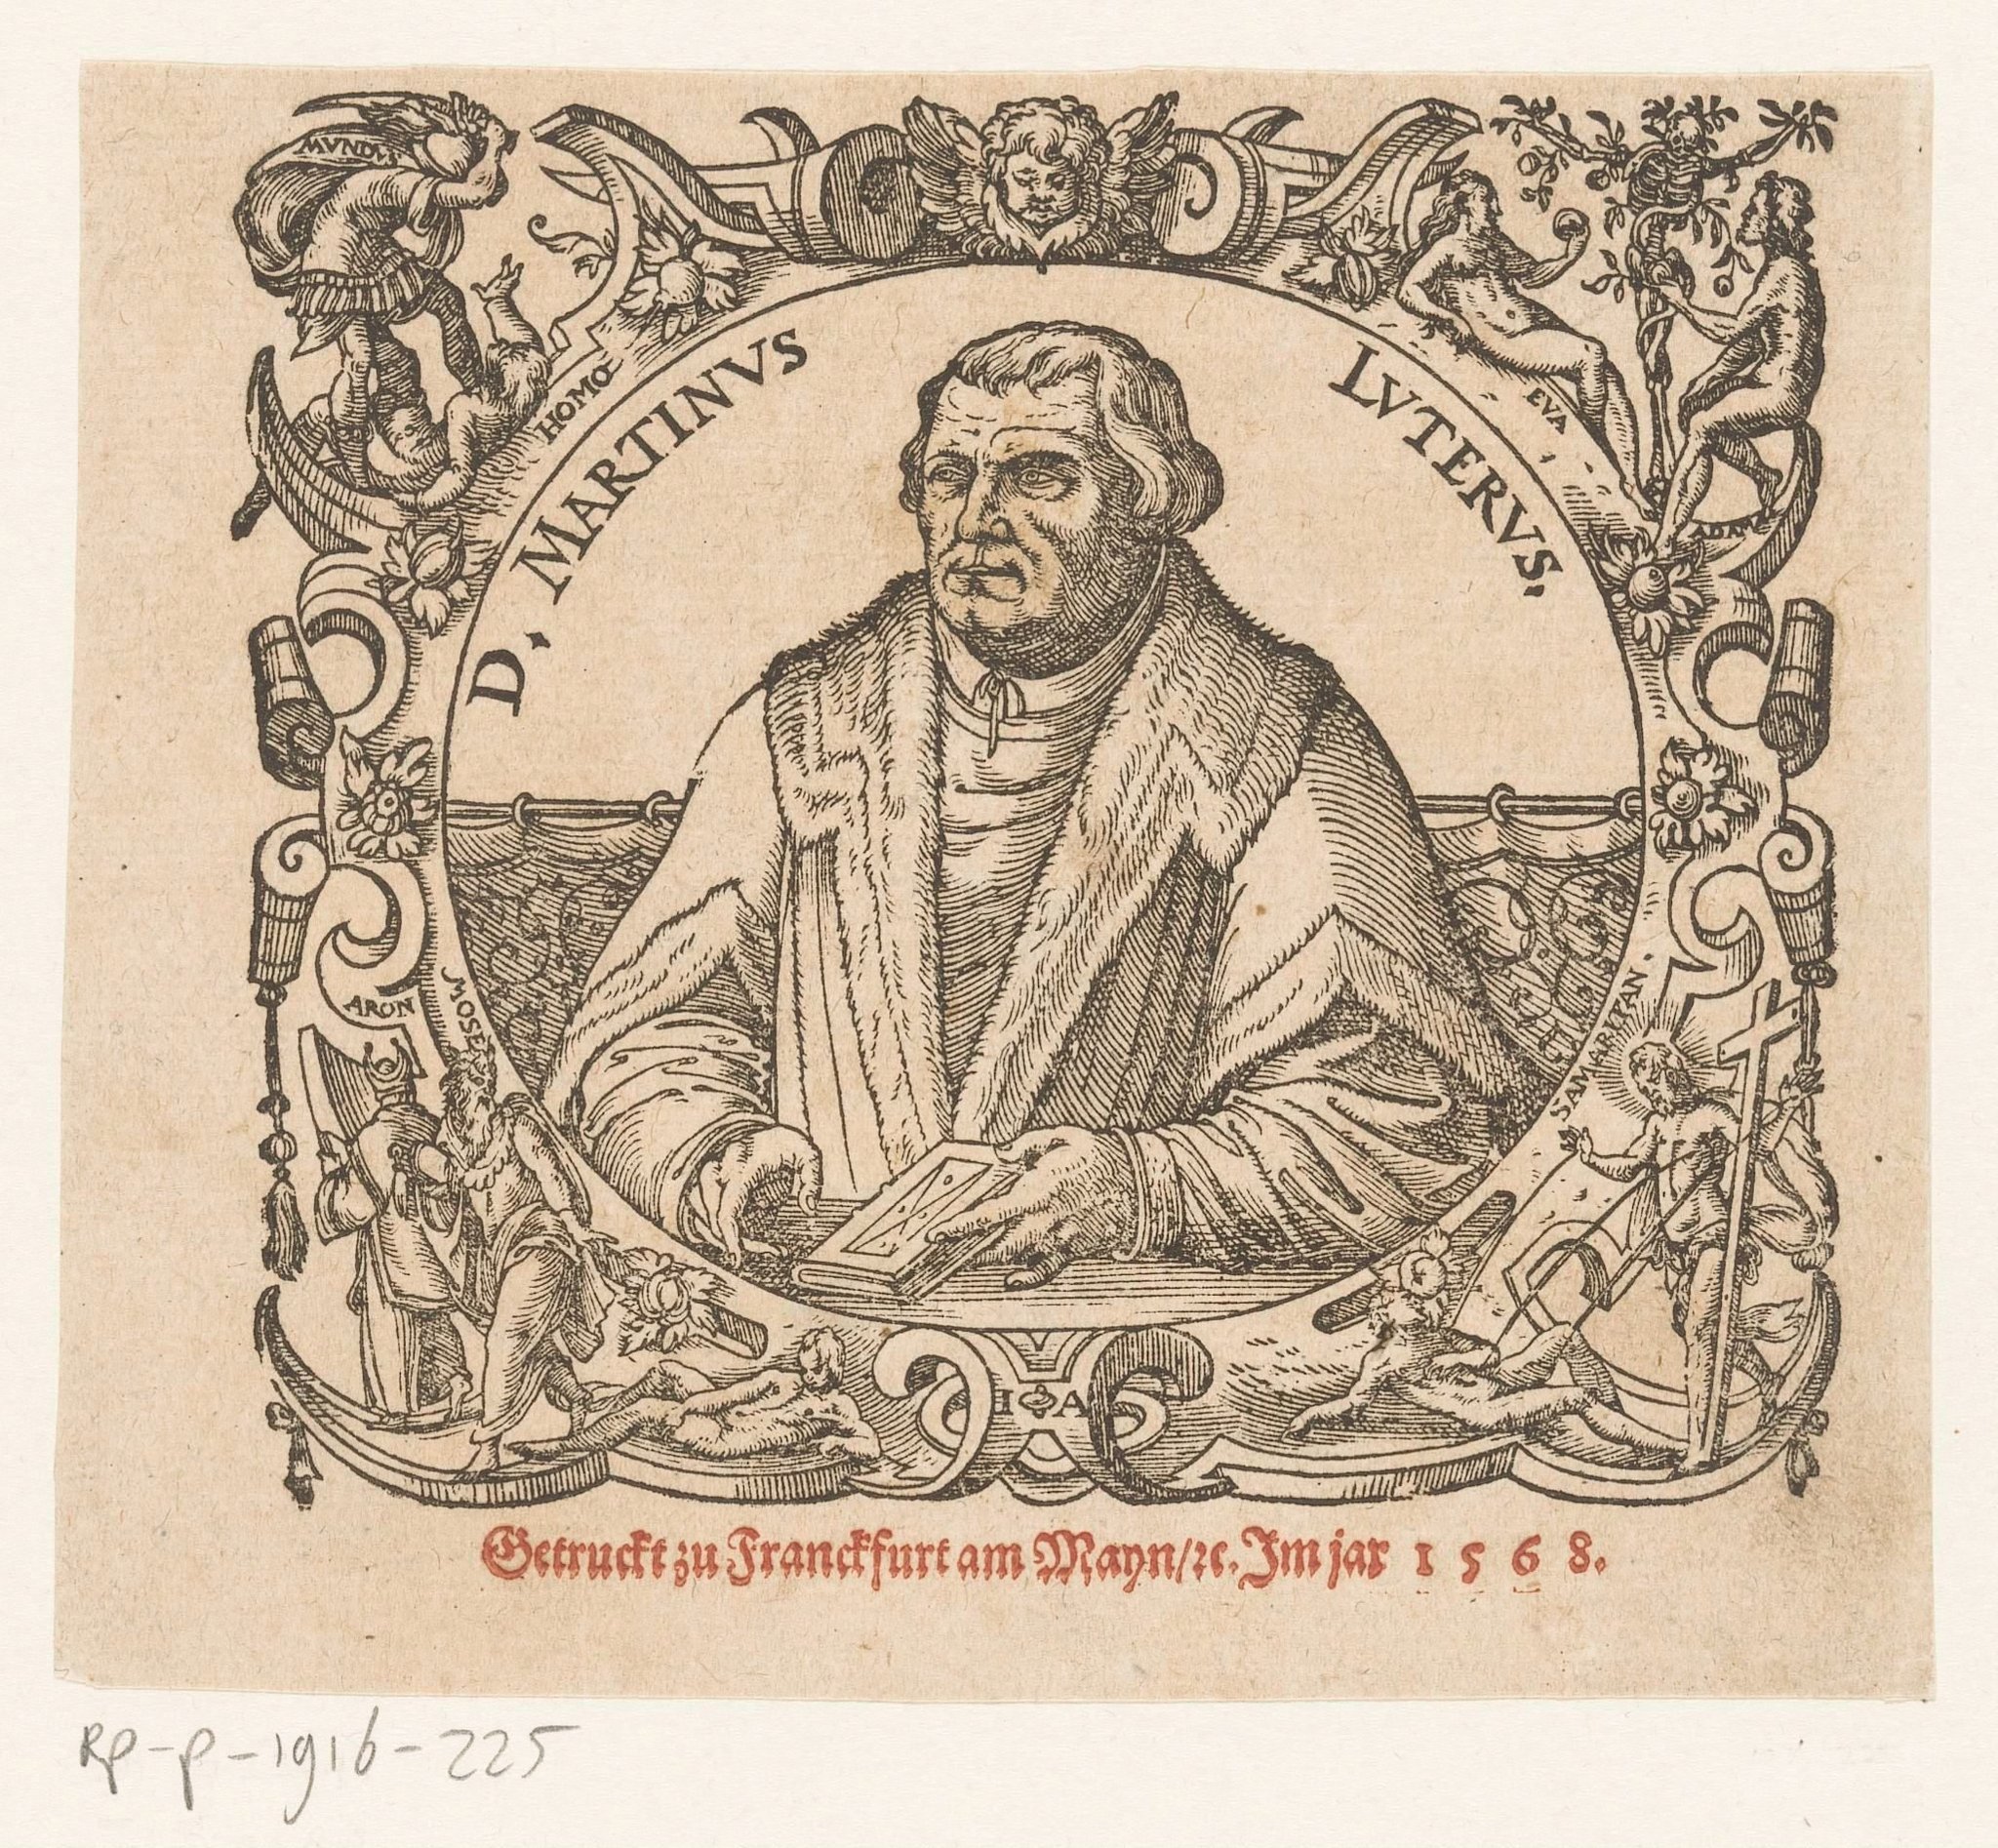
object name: print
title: Portret van Martin Luther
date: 1568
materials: paper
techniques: woodcut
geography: frankfurt am main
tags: martin luther, theologian, the good samaritan (luke 10:30-37), adam and eve holding (and possibly eating) the fruit, historical persons, the book exodus: story of moses and aaron, book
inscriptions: collector's mark: Lugt 2228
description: Prent gebruikt voor verschillende publicaties tussen 1568 en 1593.